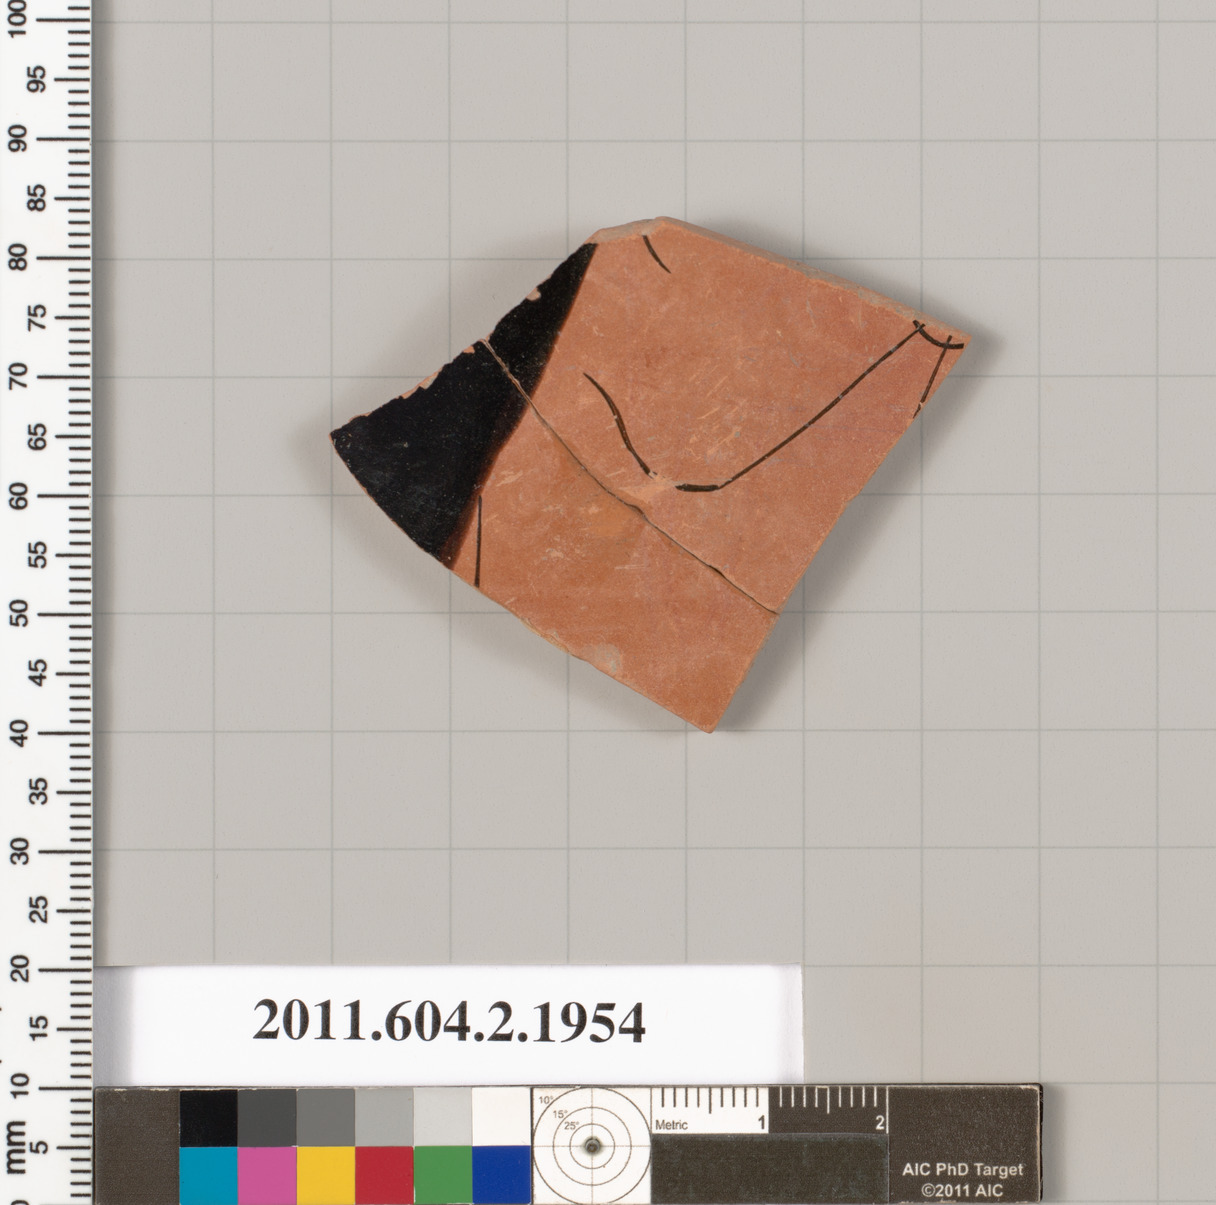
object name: neck amphora fragment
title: Terracotta fragment of a Nolan neck-amphora (jar)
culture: greek, attic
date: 475-460 BCE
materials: terracotta